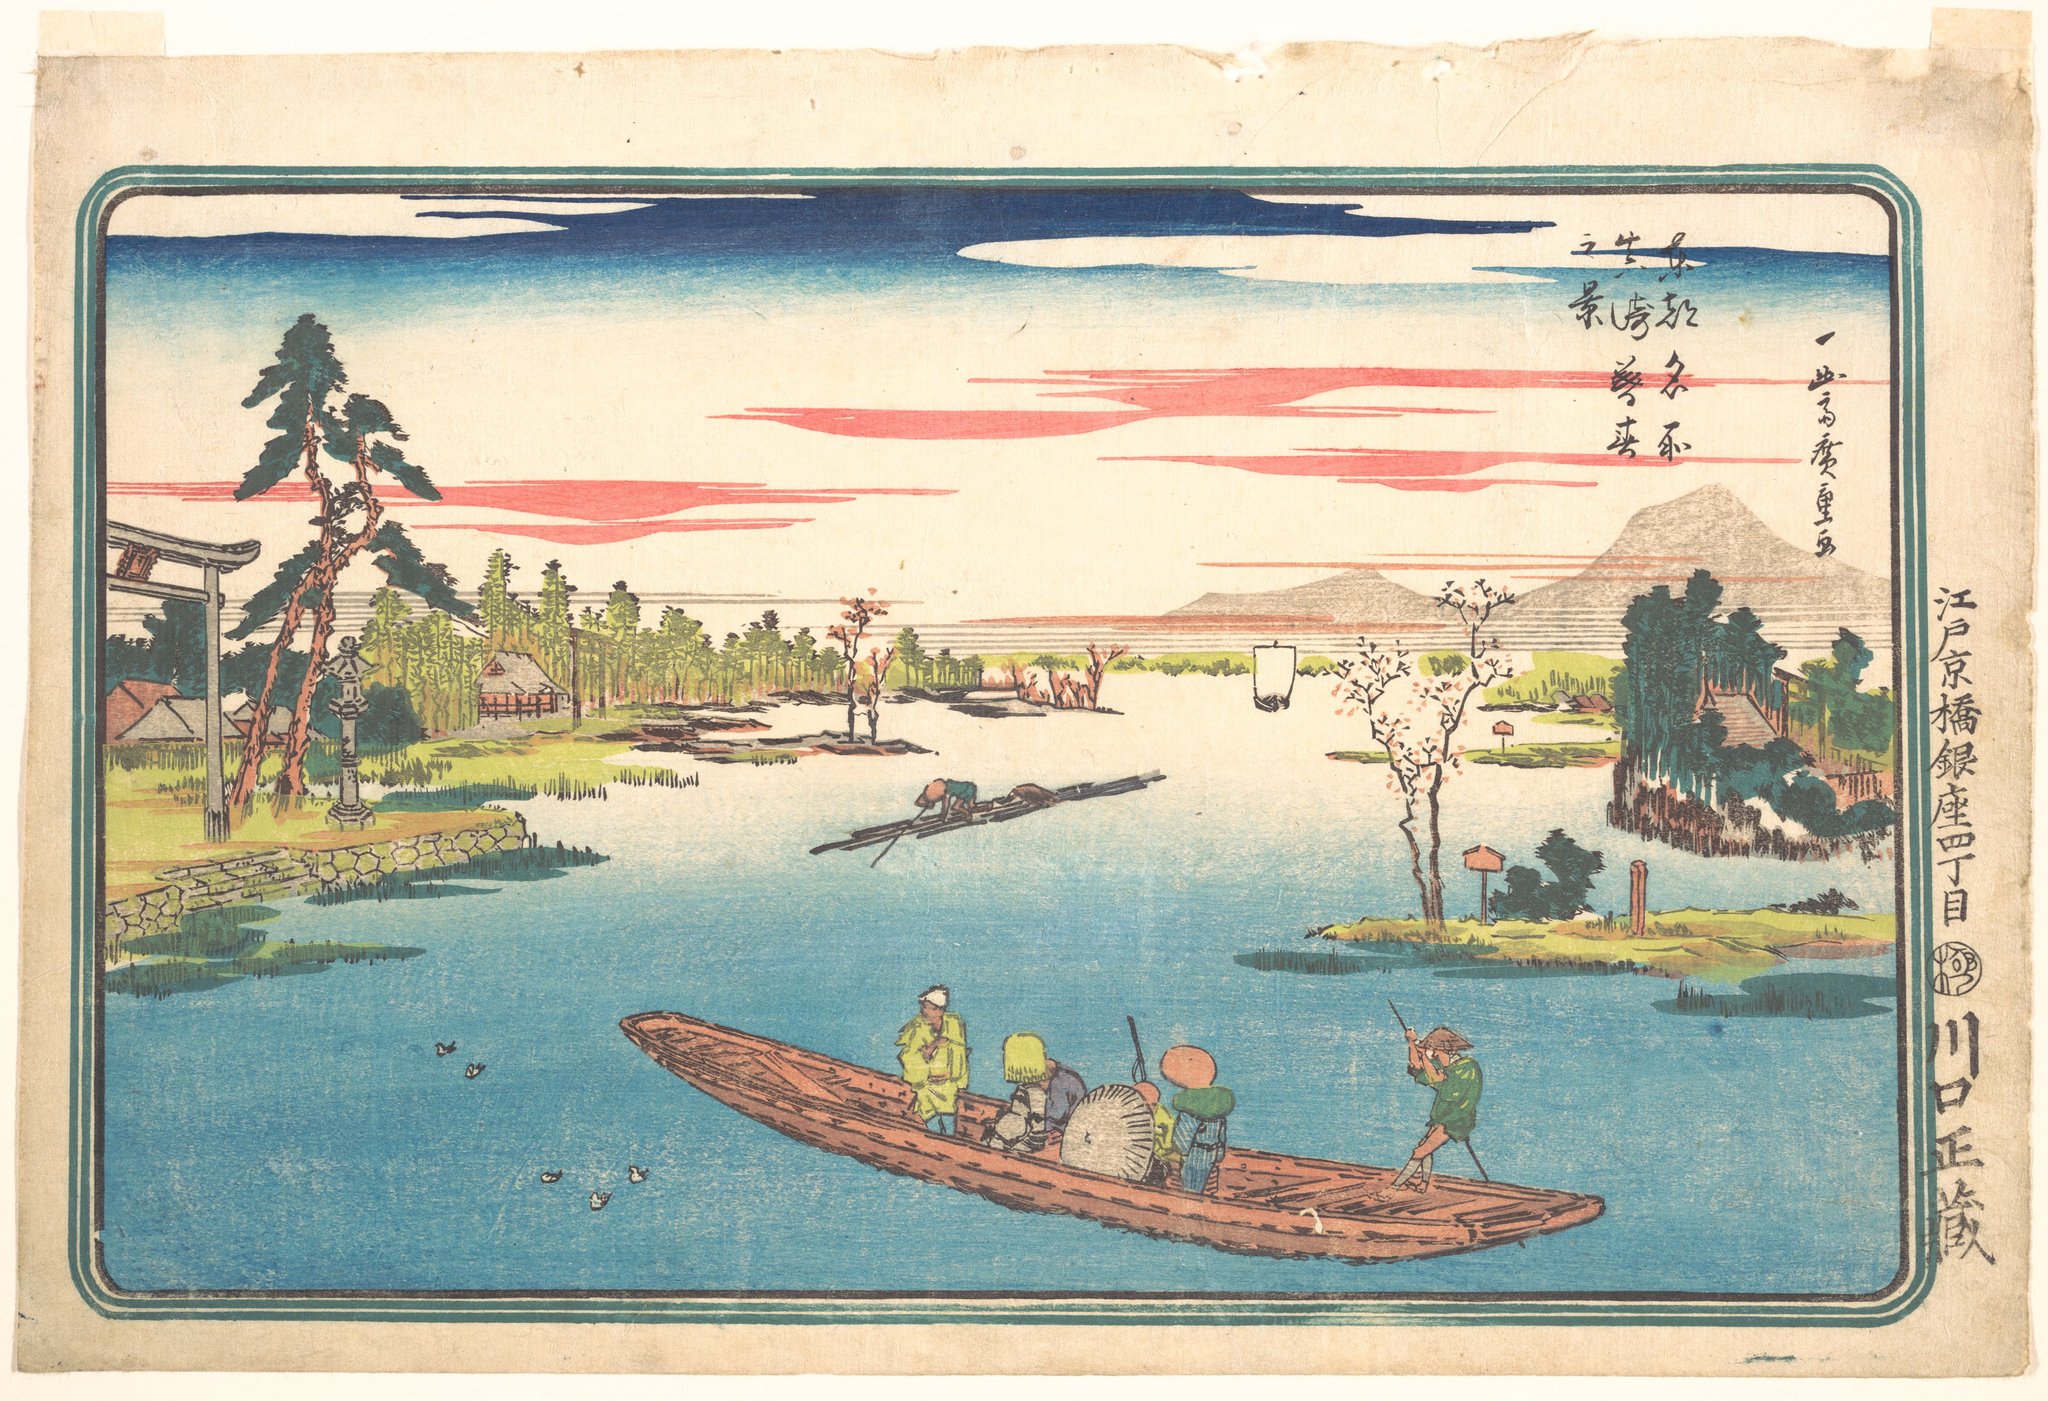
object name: print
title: A View of Late Spring at Masaki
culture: japanese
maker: utagawa hiroshige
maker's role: artist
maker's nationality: japanese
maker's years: 1797-1858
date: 1831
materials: ink, paper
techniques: woodblock print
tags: human figures,landscapes,boats